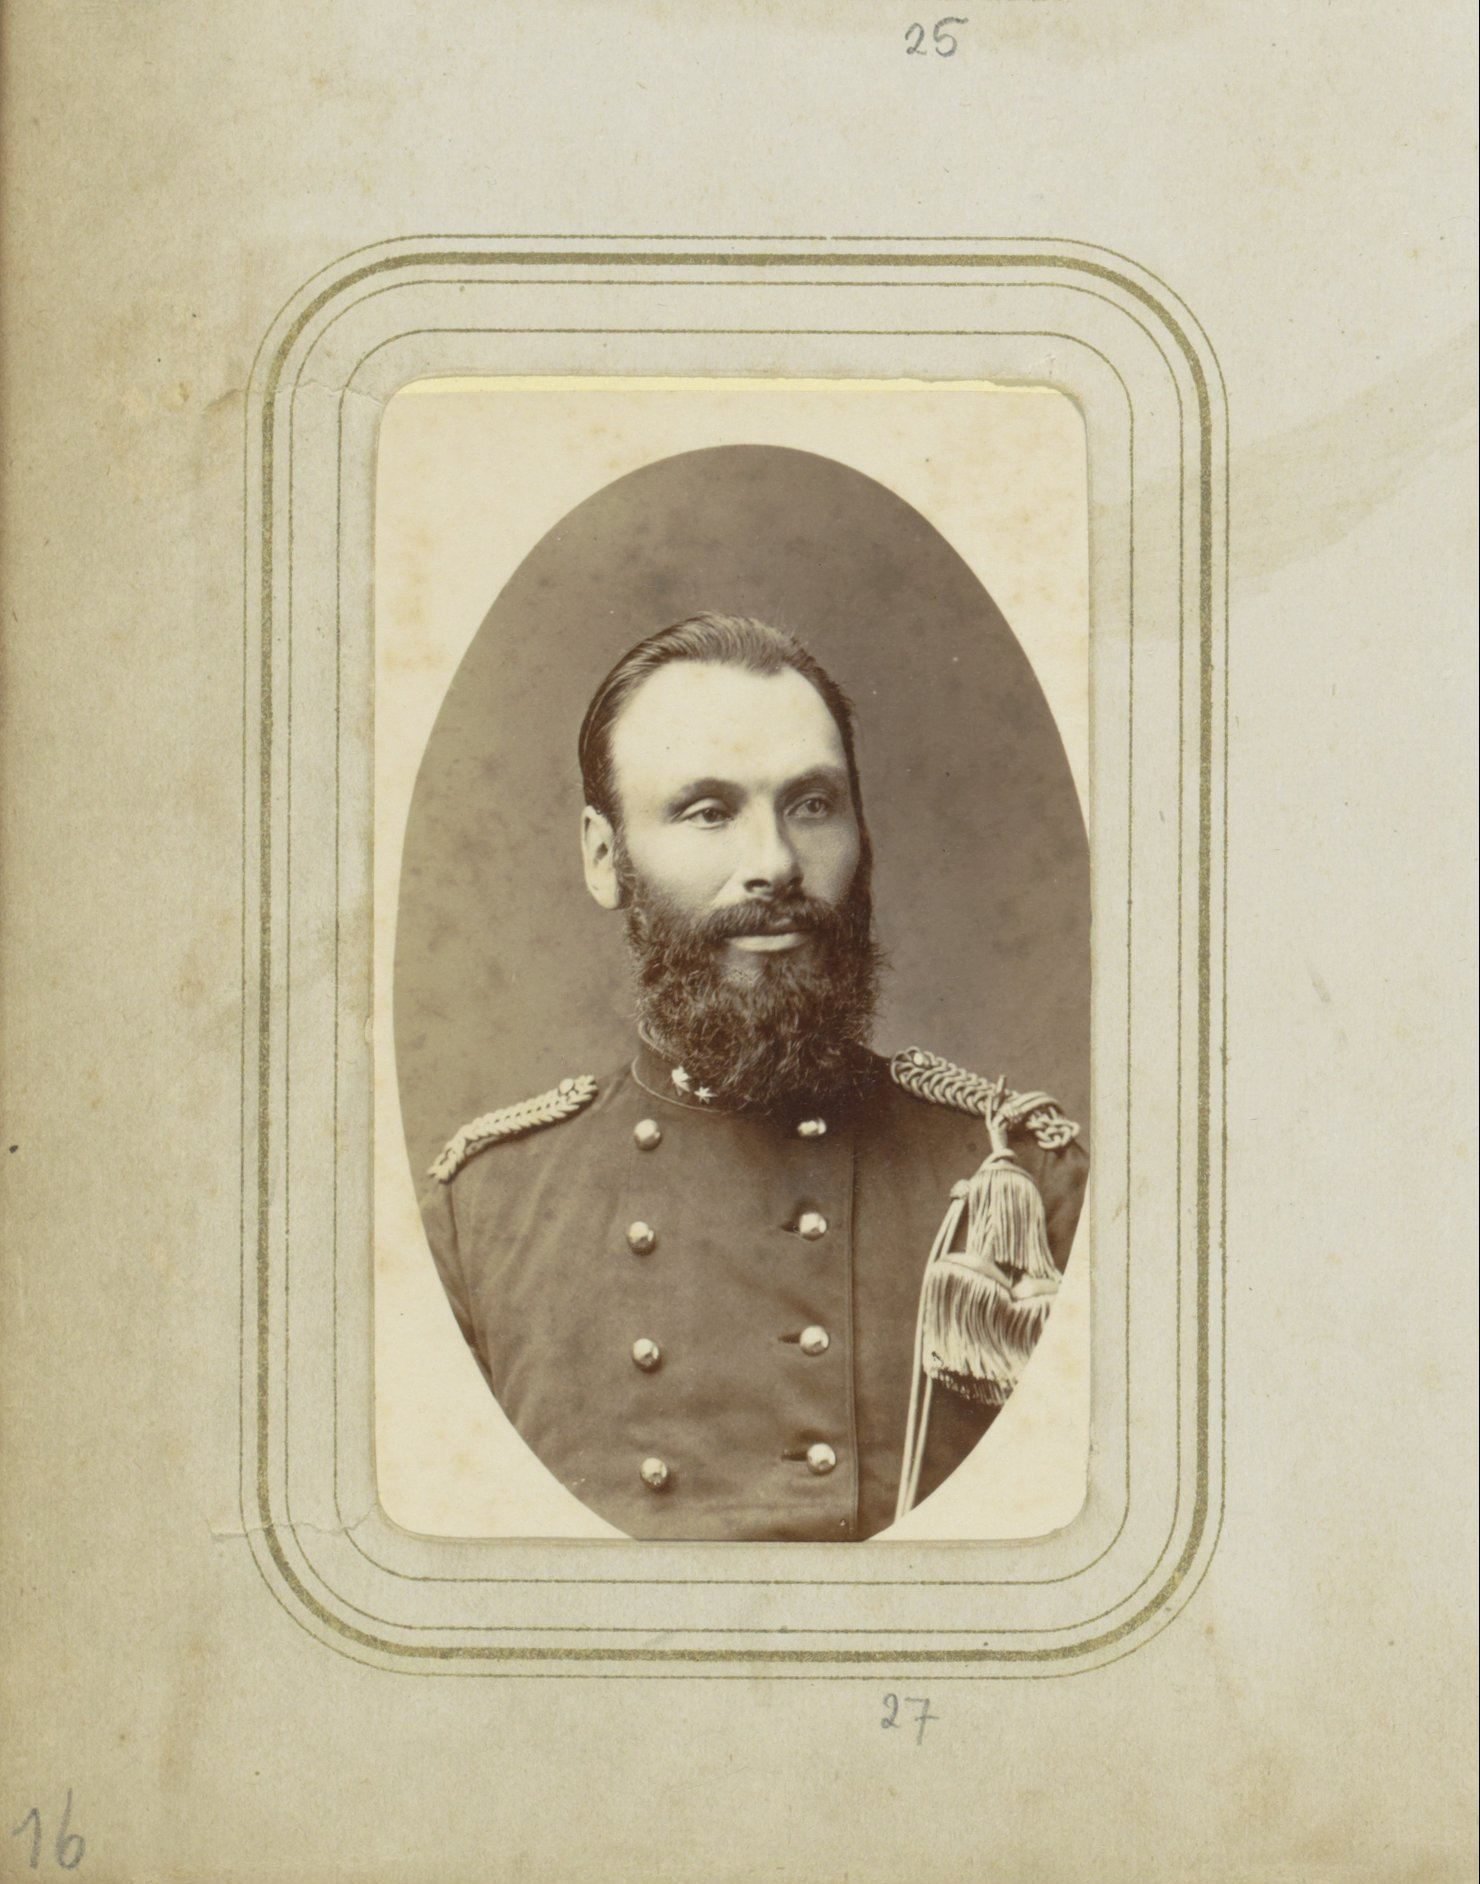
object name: carte de visite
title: Portret van een man met een baard in militair kostuum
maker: bernardus bruining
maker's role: fotograaf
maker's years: 1834-1900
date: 1860-1877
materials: cardboard, photographic support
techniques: albumen print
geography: leiden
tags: historical persons, family, relationship, descent, medals and other marks of military honour, hairdress, (military) uniforms, beard, the hague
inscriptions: address: ‘Leiden’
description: Onderdeel van Familiealbum van H.W.F. Ligtenberg en L.M. Swart met 149 foto's en cartes-de-visite.